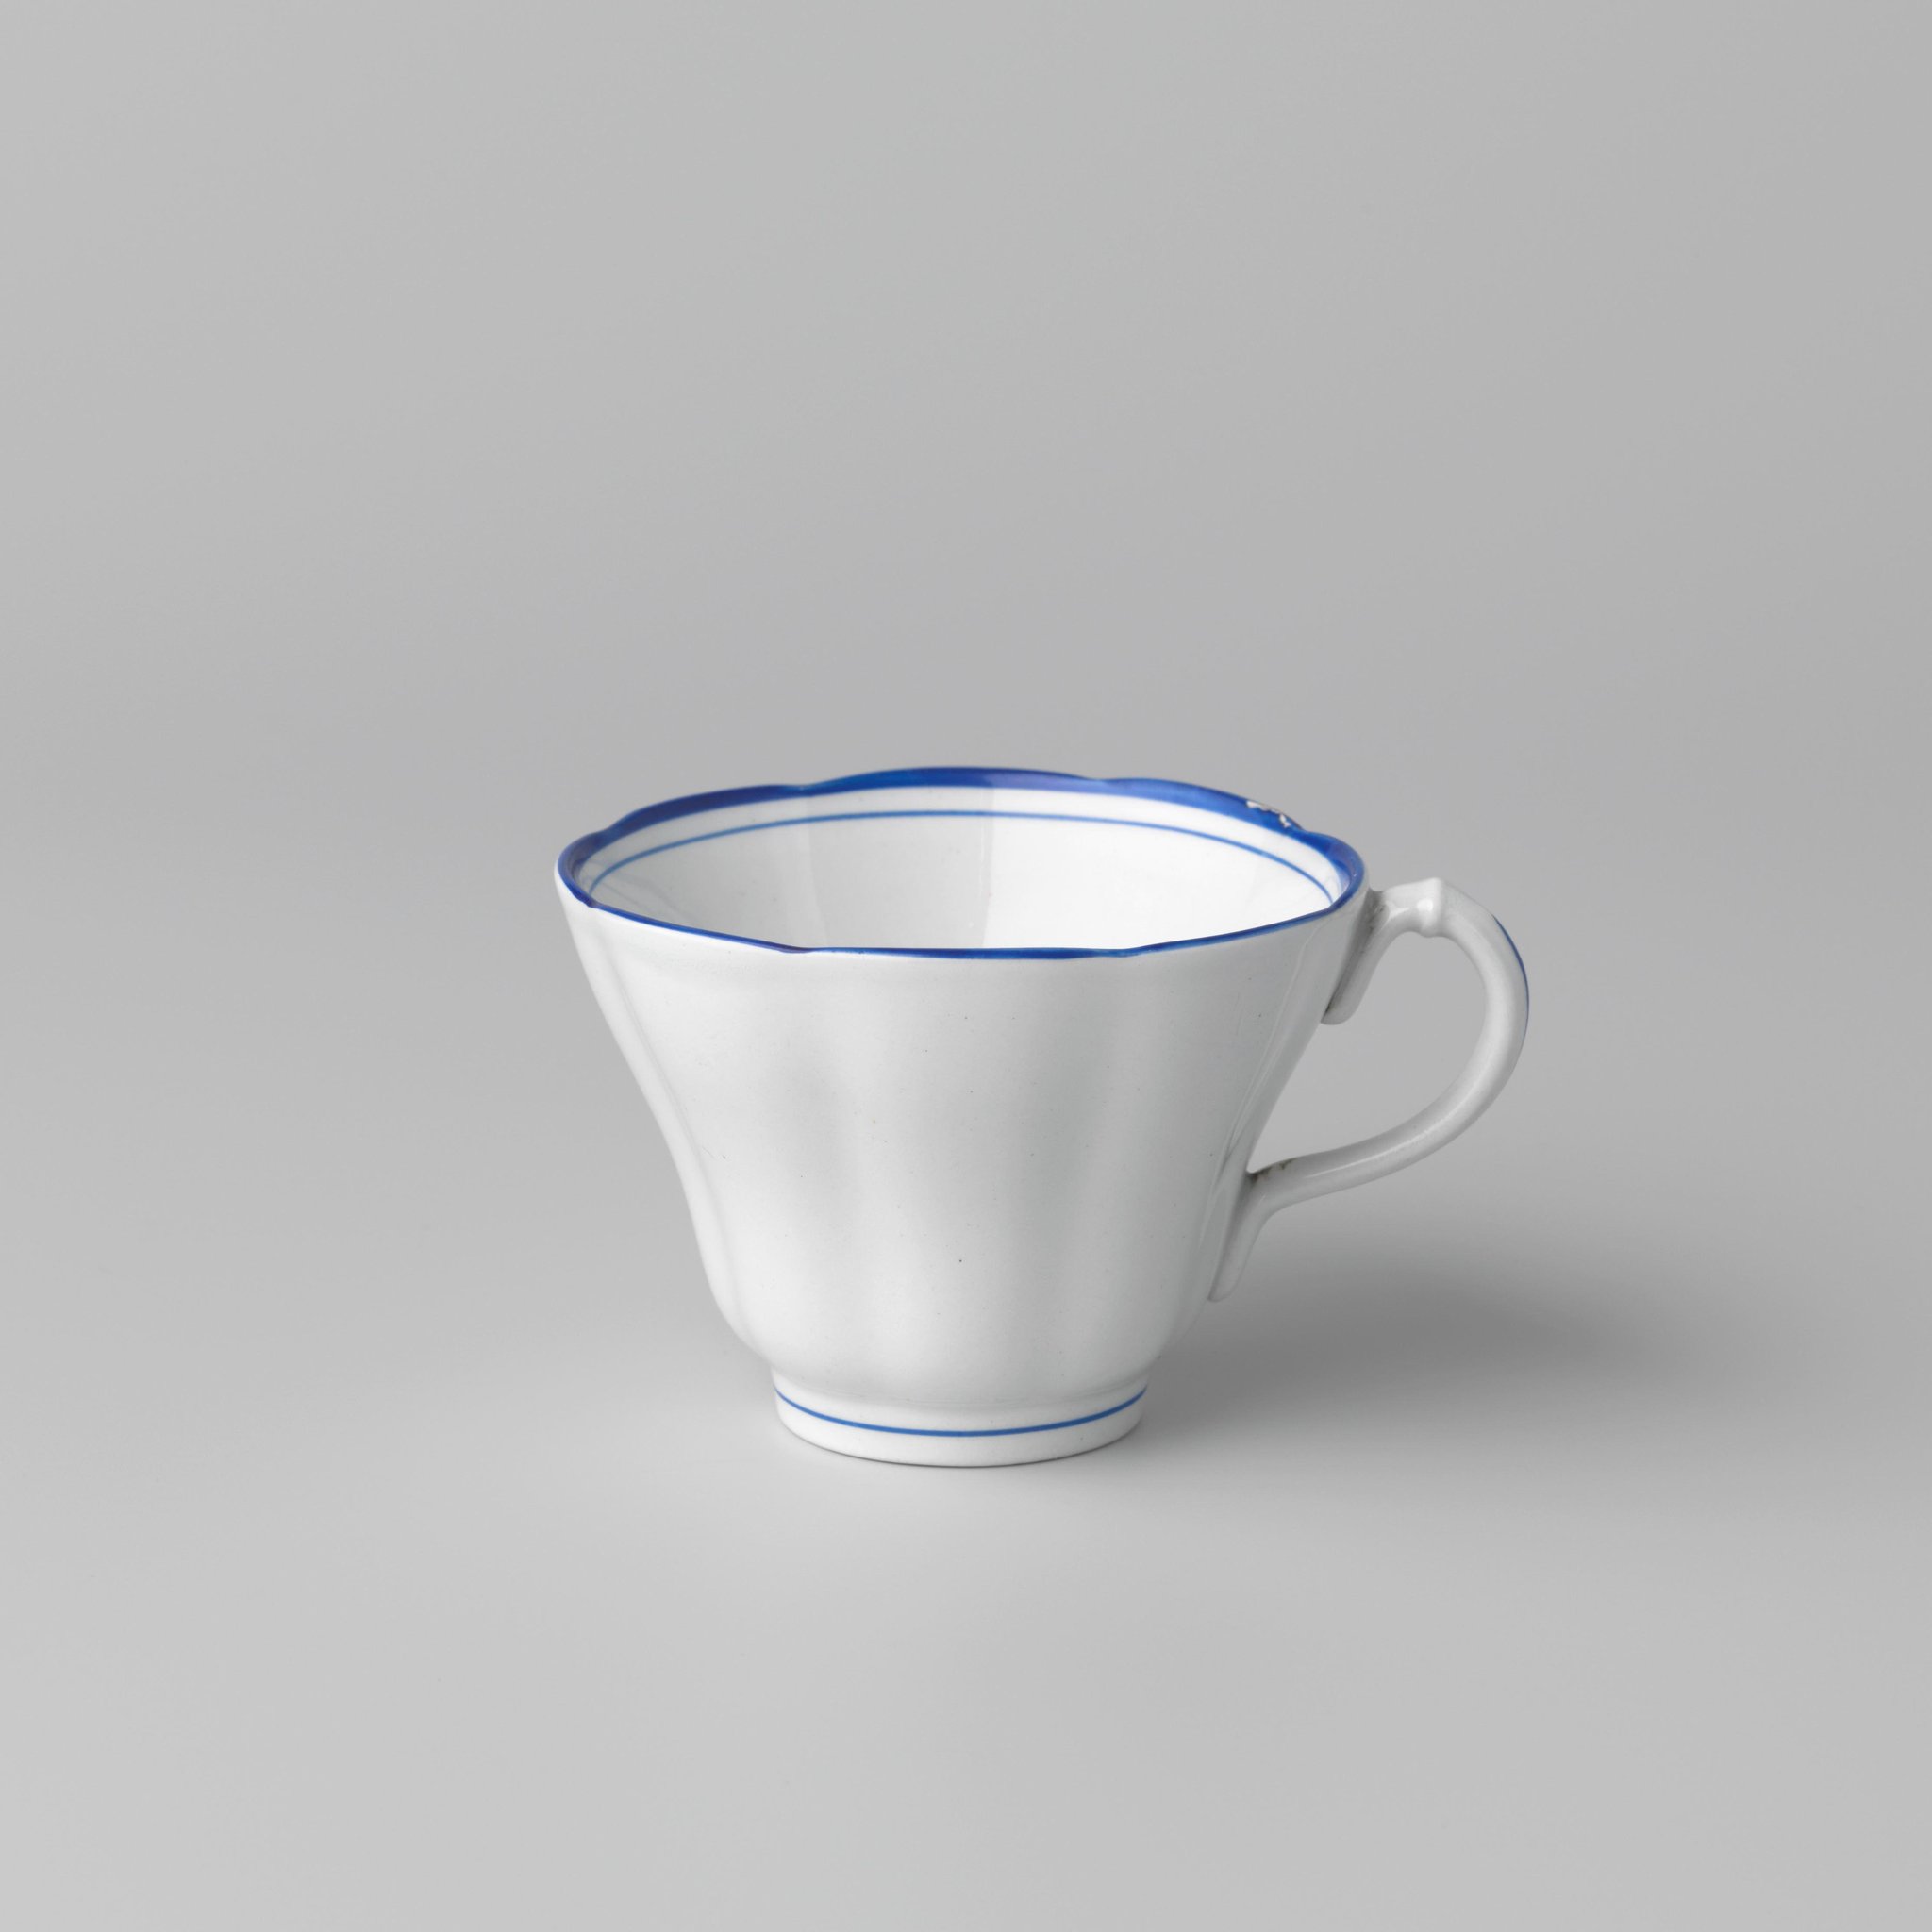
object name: cup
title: Kop met oor, wit, met blauwe biezen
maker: petrus regout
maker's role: plateelbakker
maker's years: 1801-1879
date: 1860-1890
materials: creamware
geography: maastricht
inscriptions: check stamp: ‘onduidelijk’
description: Kop met oor van aardewerk, behorend bij een koffie- en theeservies, wit, met blauwe biezen.